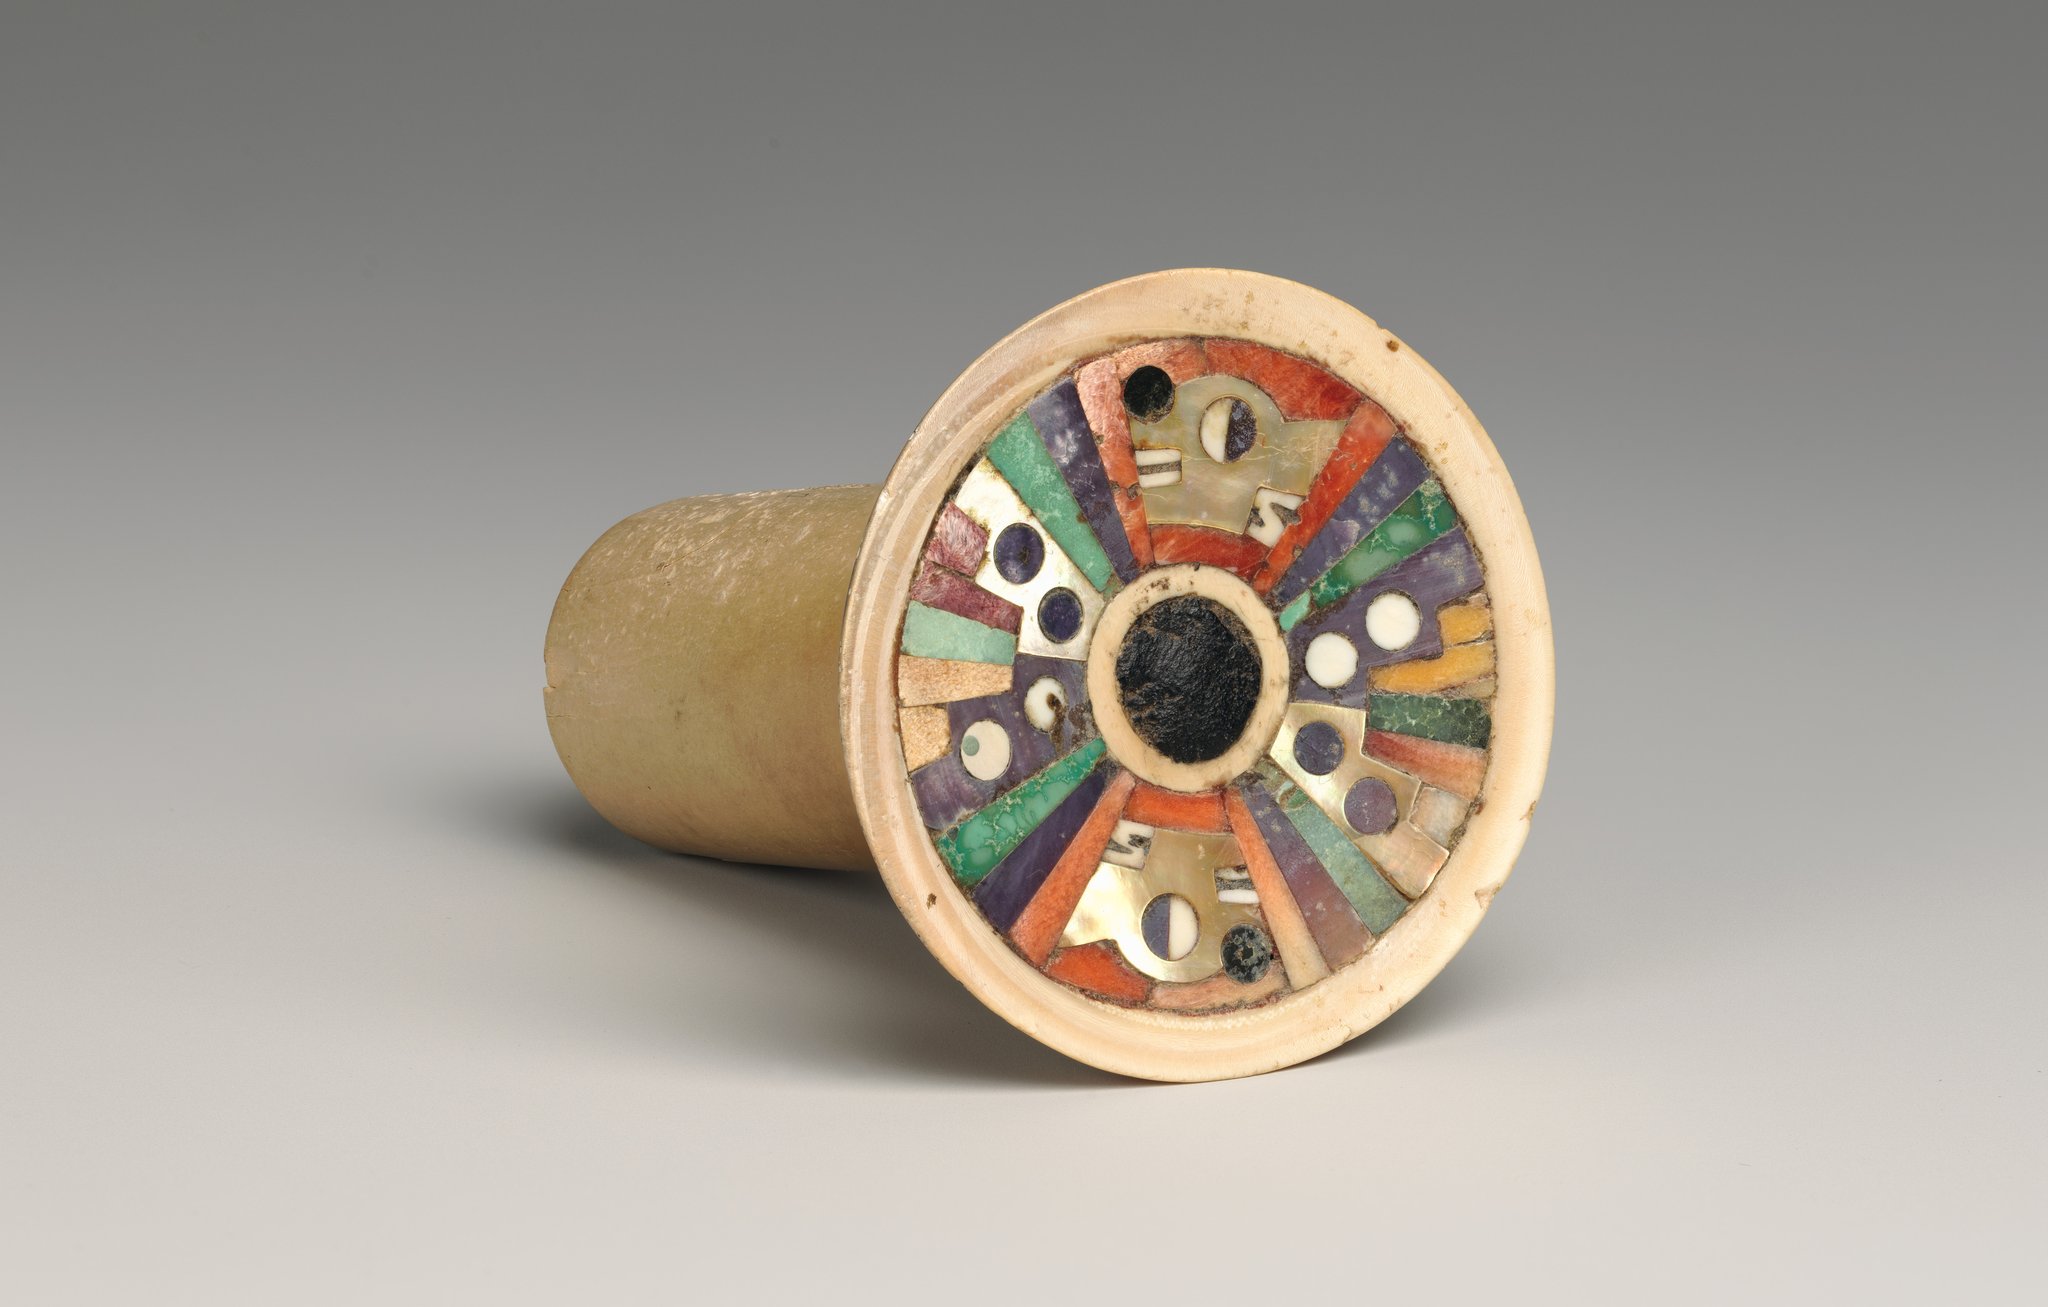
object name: earflare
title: Ear ornament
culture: wari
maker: wari artist(s)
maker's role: artist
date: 650-1000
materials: bone, shell, stone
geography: peru